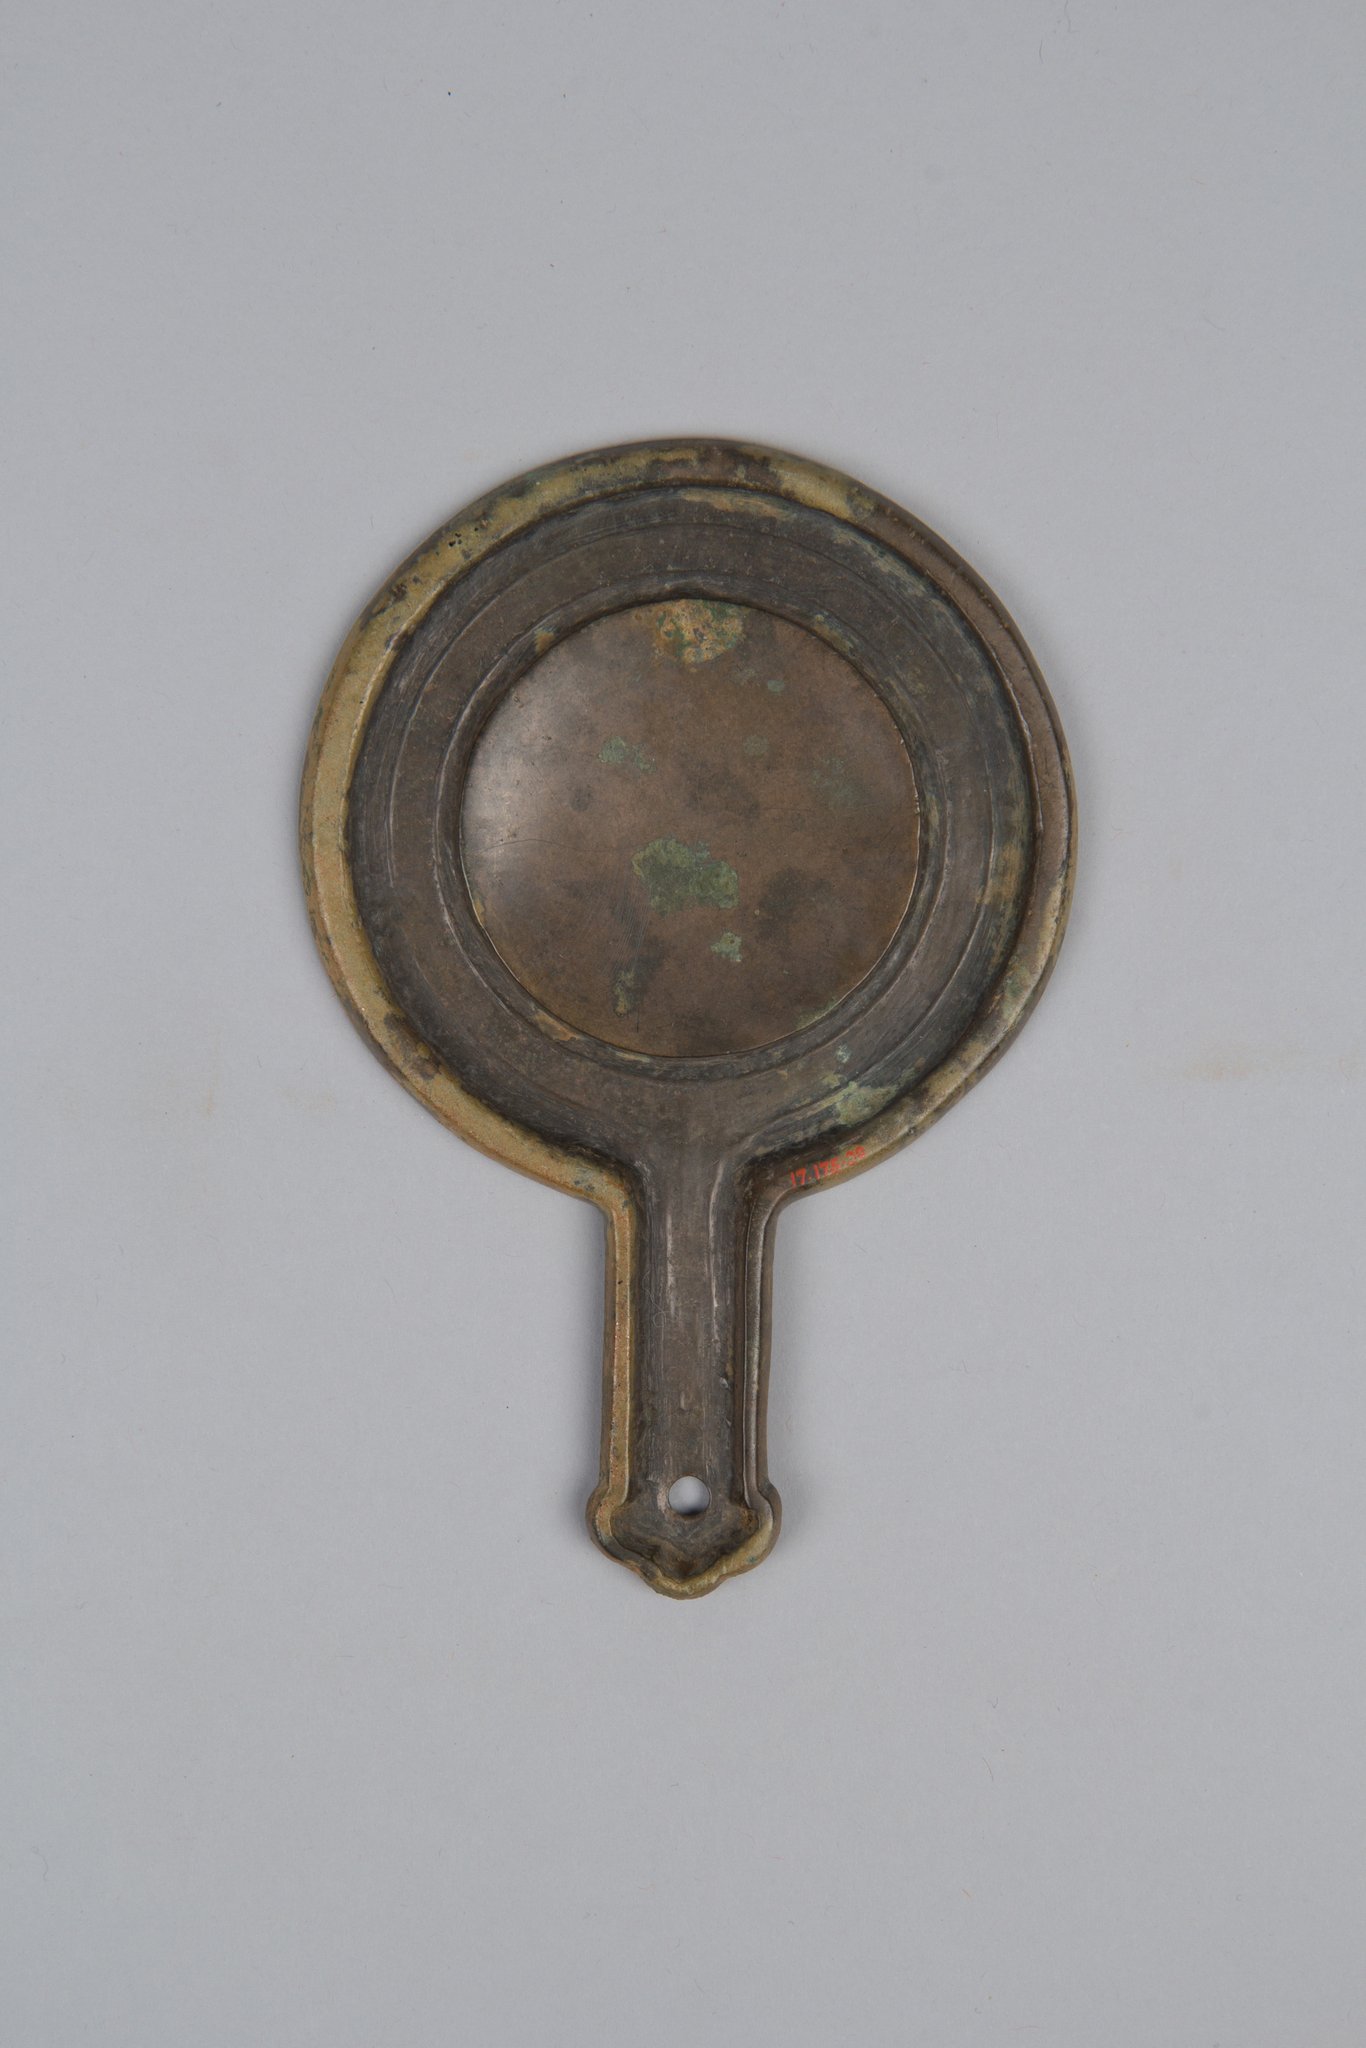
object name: mirror handle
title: Mirror with Handle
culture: korean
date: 918-1392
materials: bronze